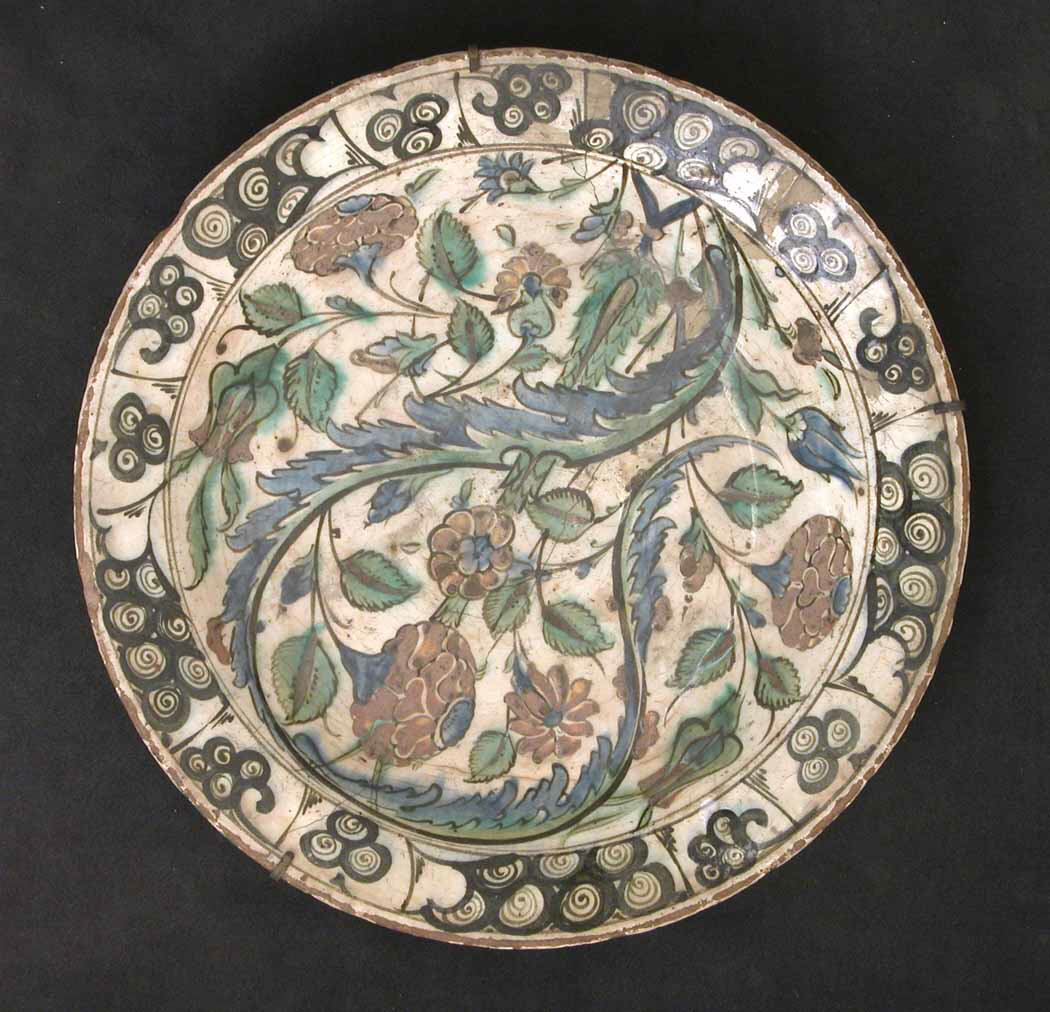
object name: dish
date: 1601-1633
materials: stonepaste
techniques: painting, underglaze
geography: turkey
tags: flowers,leaves